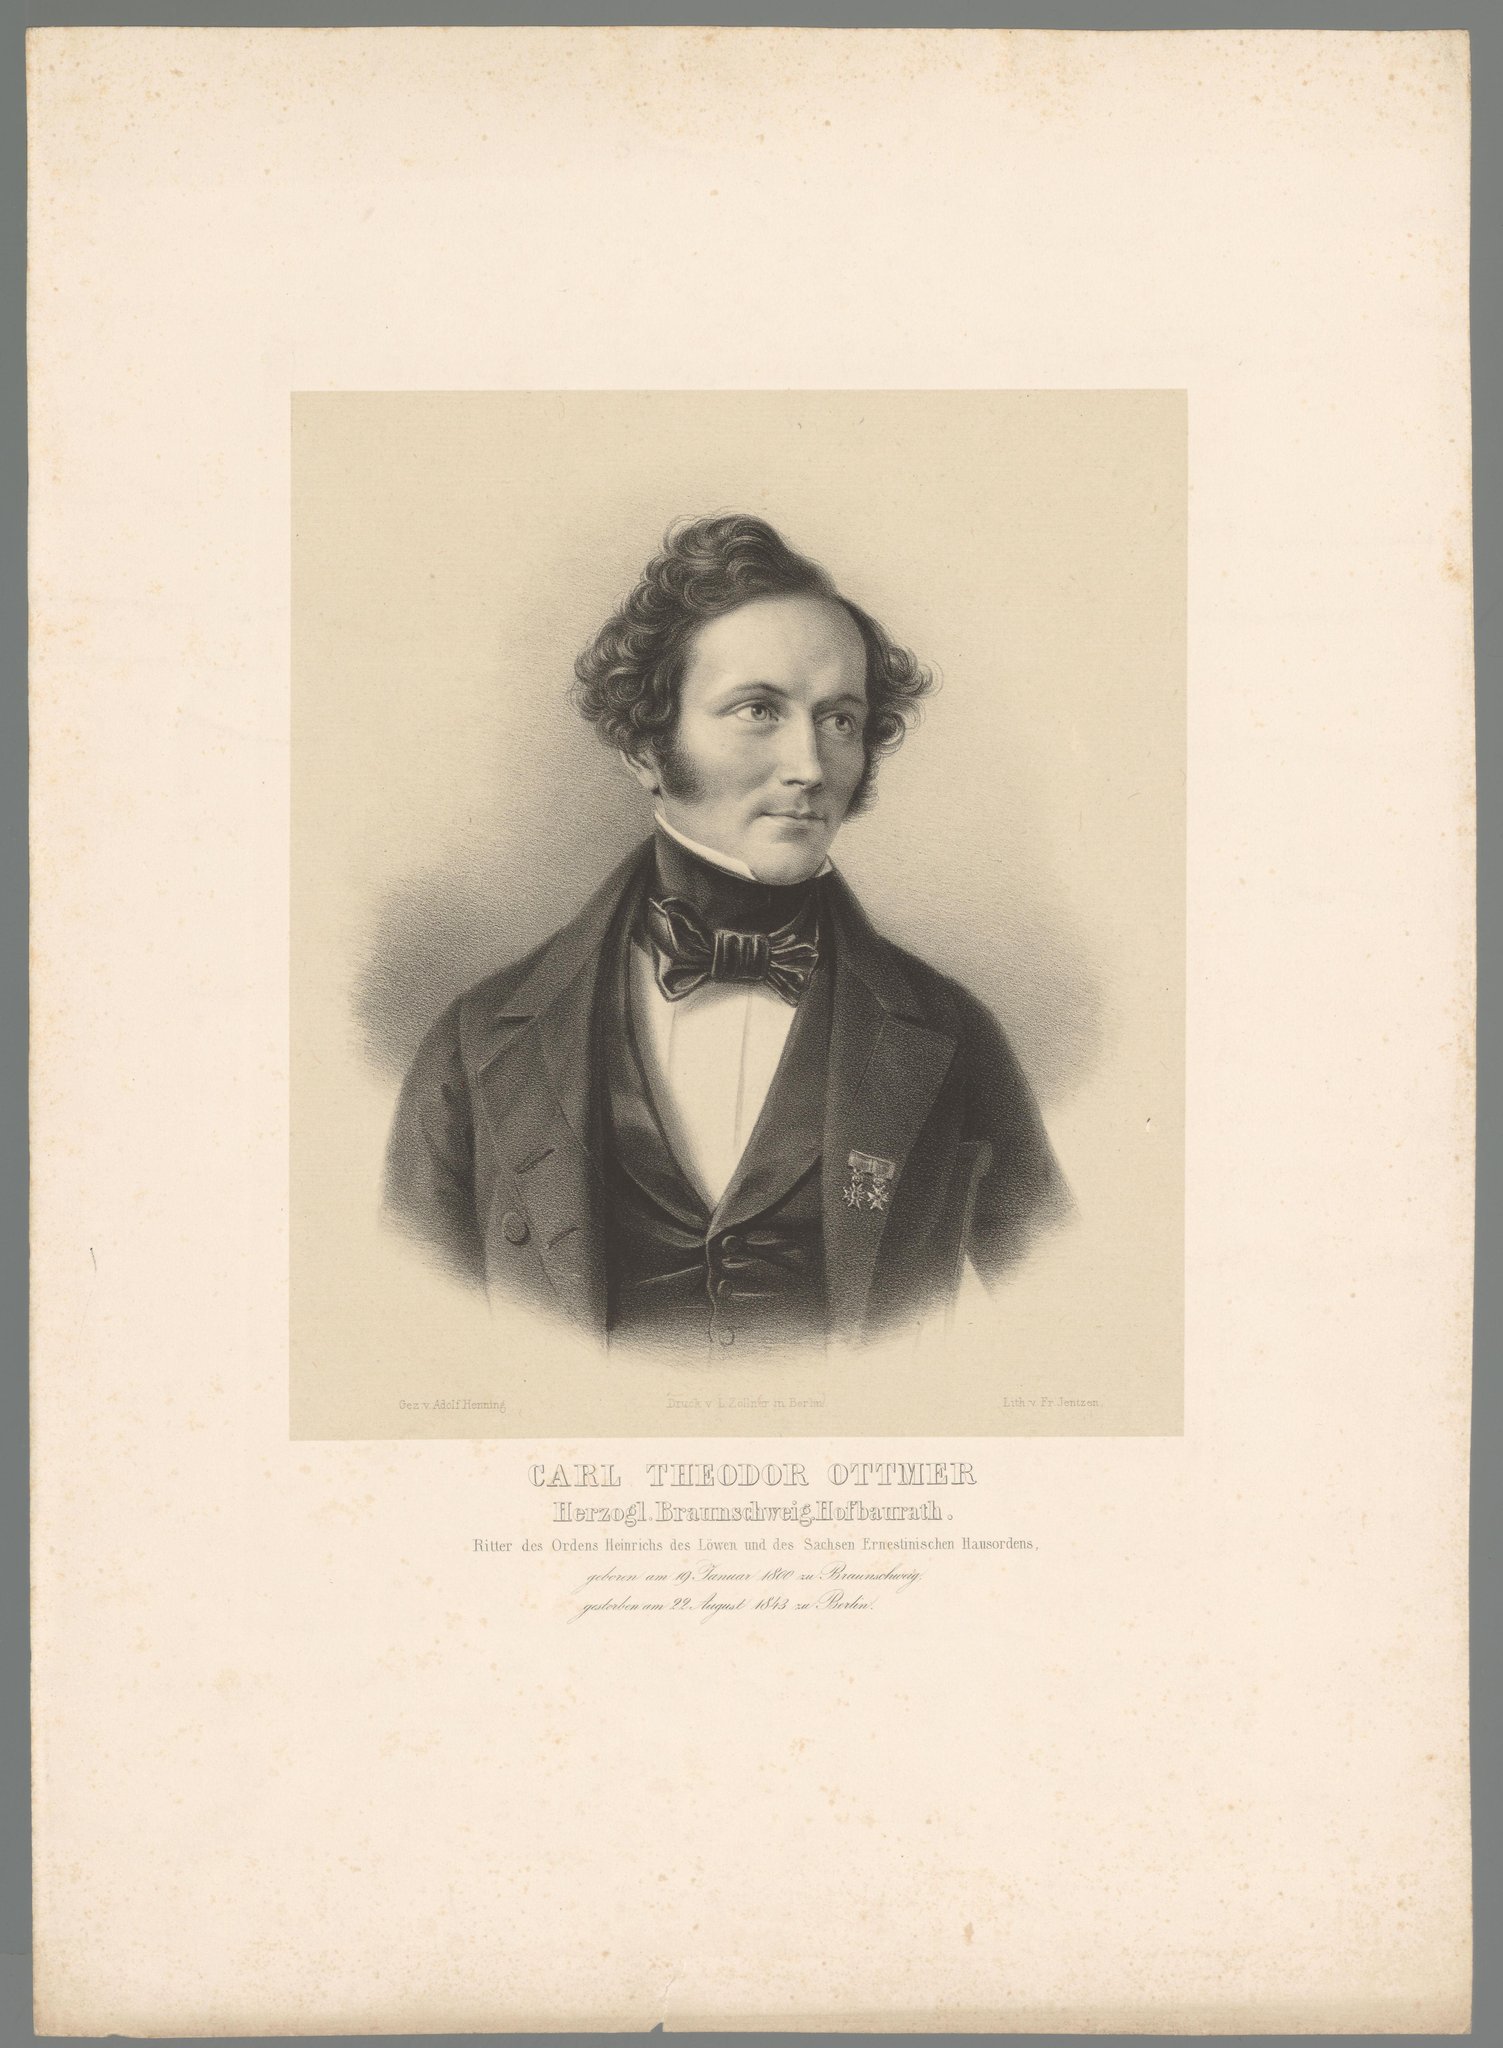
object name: print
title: Carl Theodor Ottmer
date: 1814-1875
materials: paper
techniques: lithograph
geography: berlin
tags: berlin, historical persons, portrait, self-portrait of architect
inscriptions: collector's mark: Lugt 2228